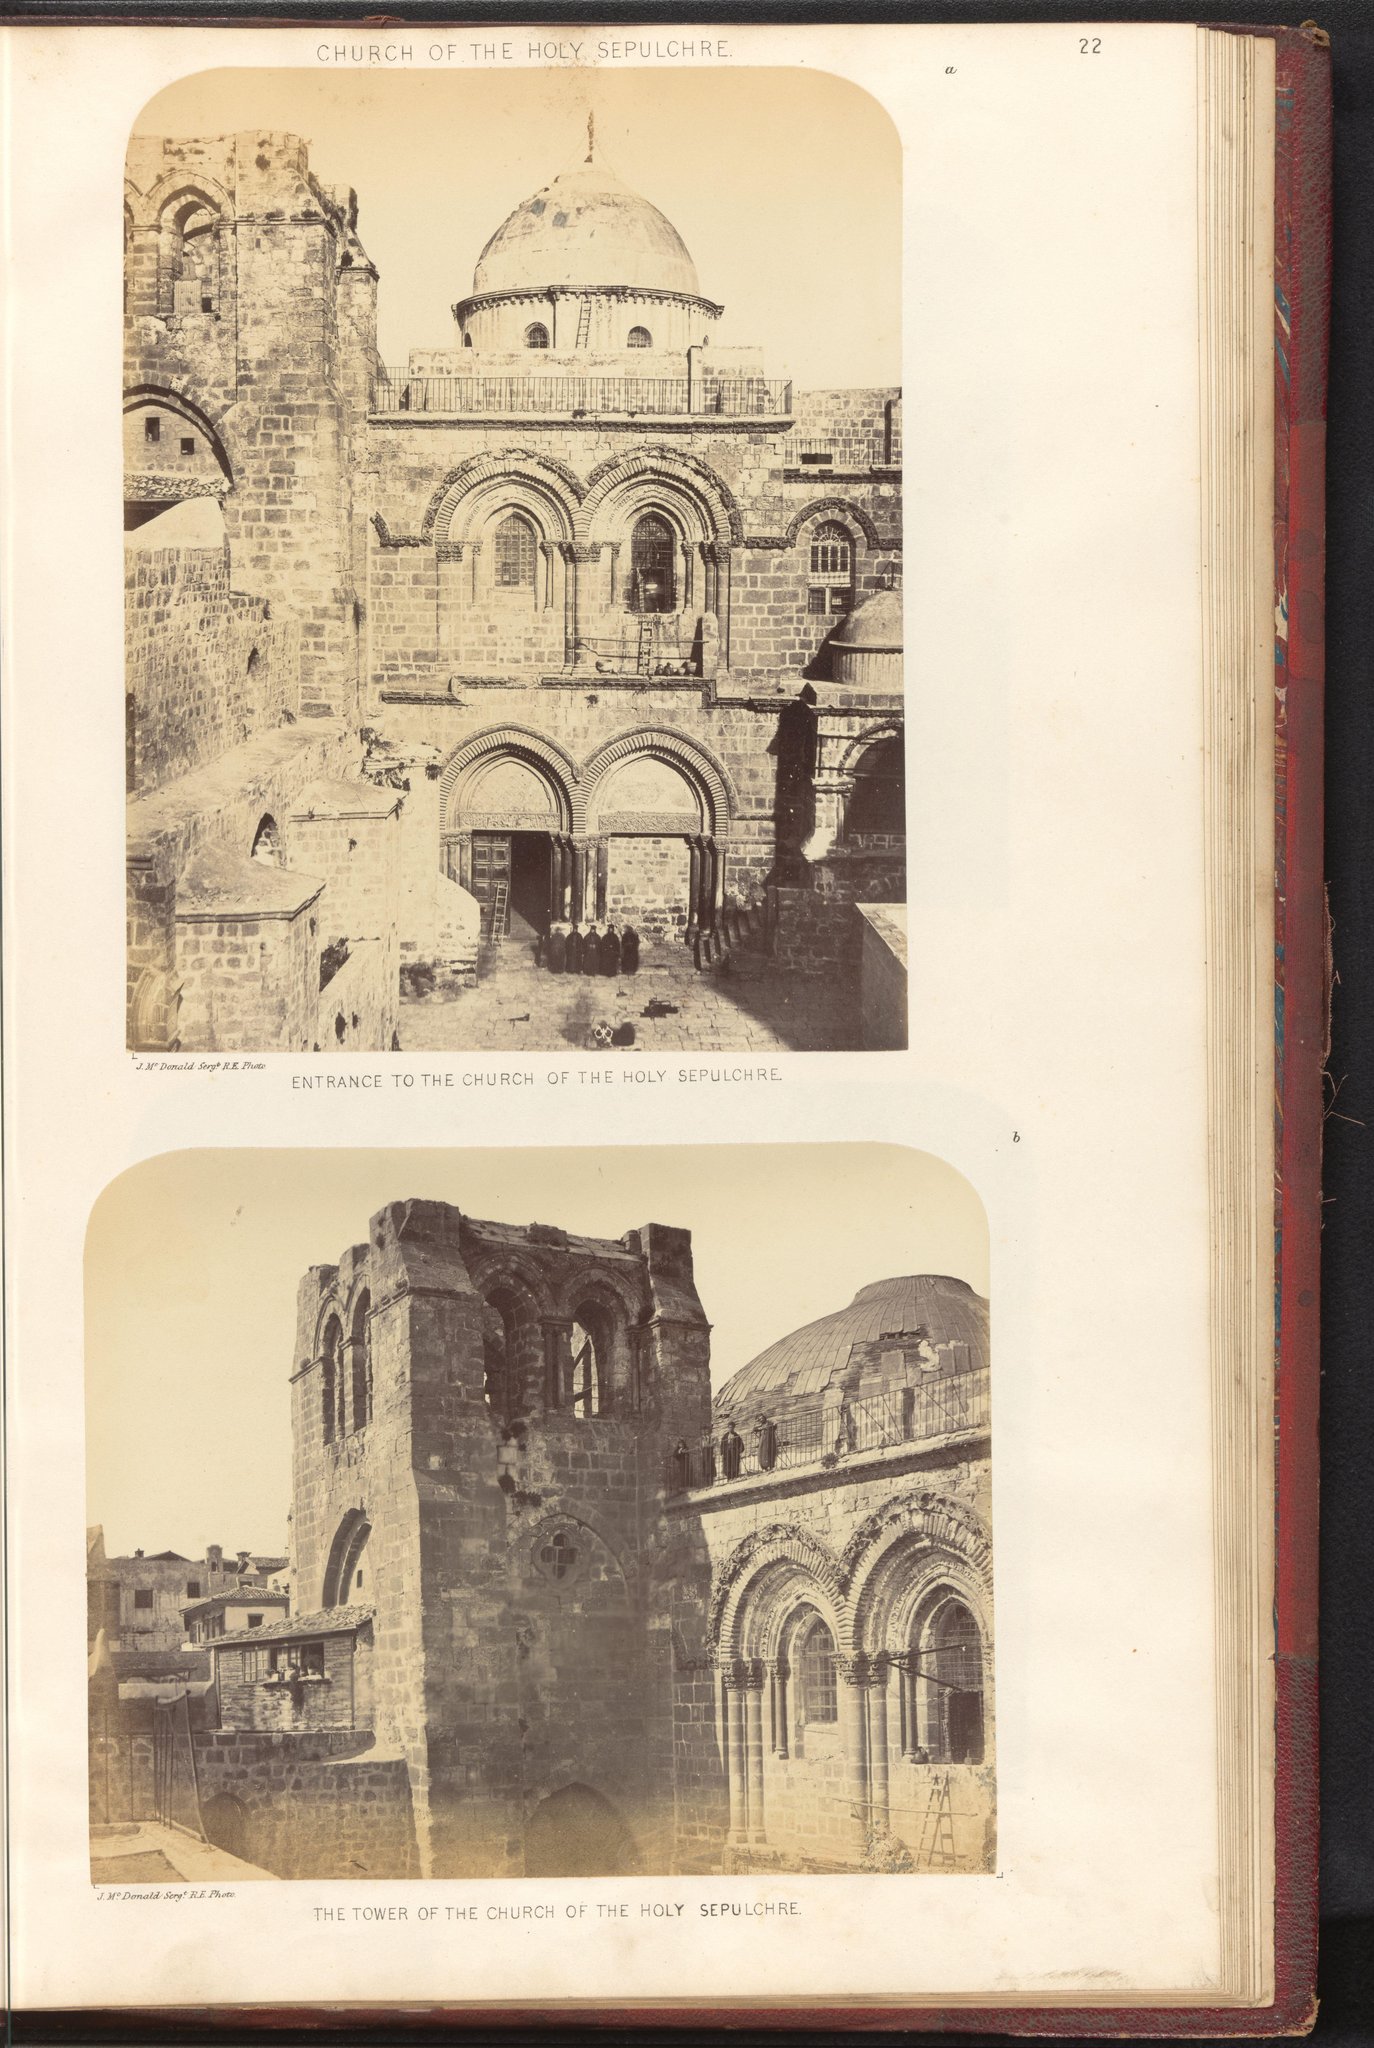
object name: page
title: Twee gezichten op de Heilig Grafkerk in Jeruzalem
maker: james mcdonald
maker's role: fotograaf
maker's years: 1822-1885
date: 1860-1865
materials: paper, photographic support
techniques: albumen print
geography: jerusalem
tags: church (exterior)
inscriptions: inscription: ‘a’, inscription: ‘b’